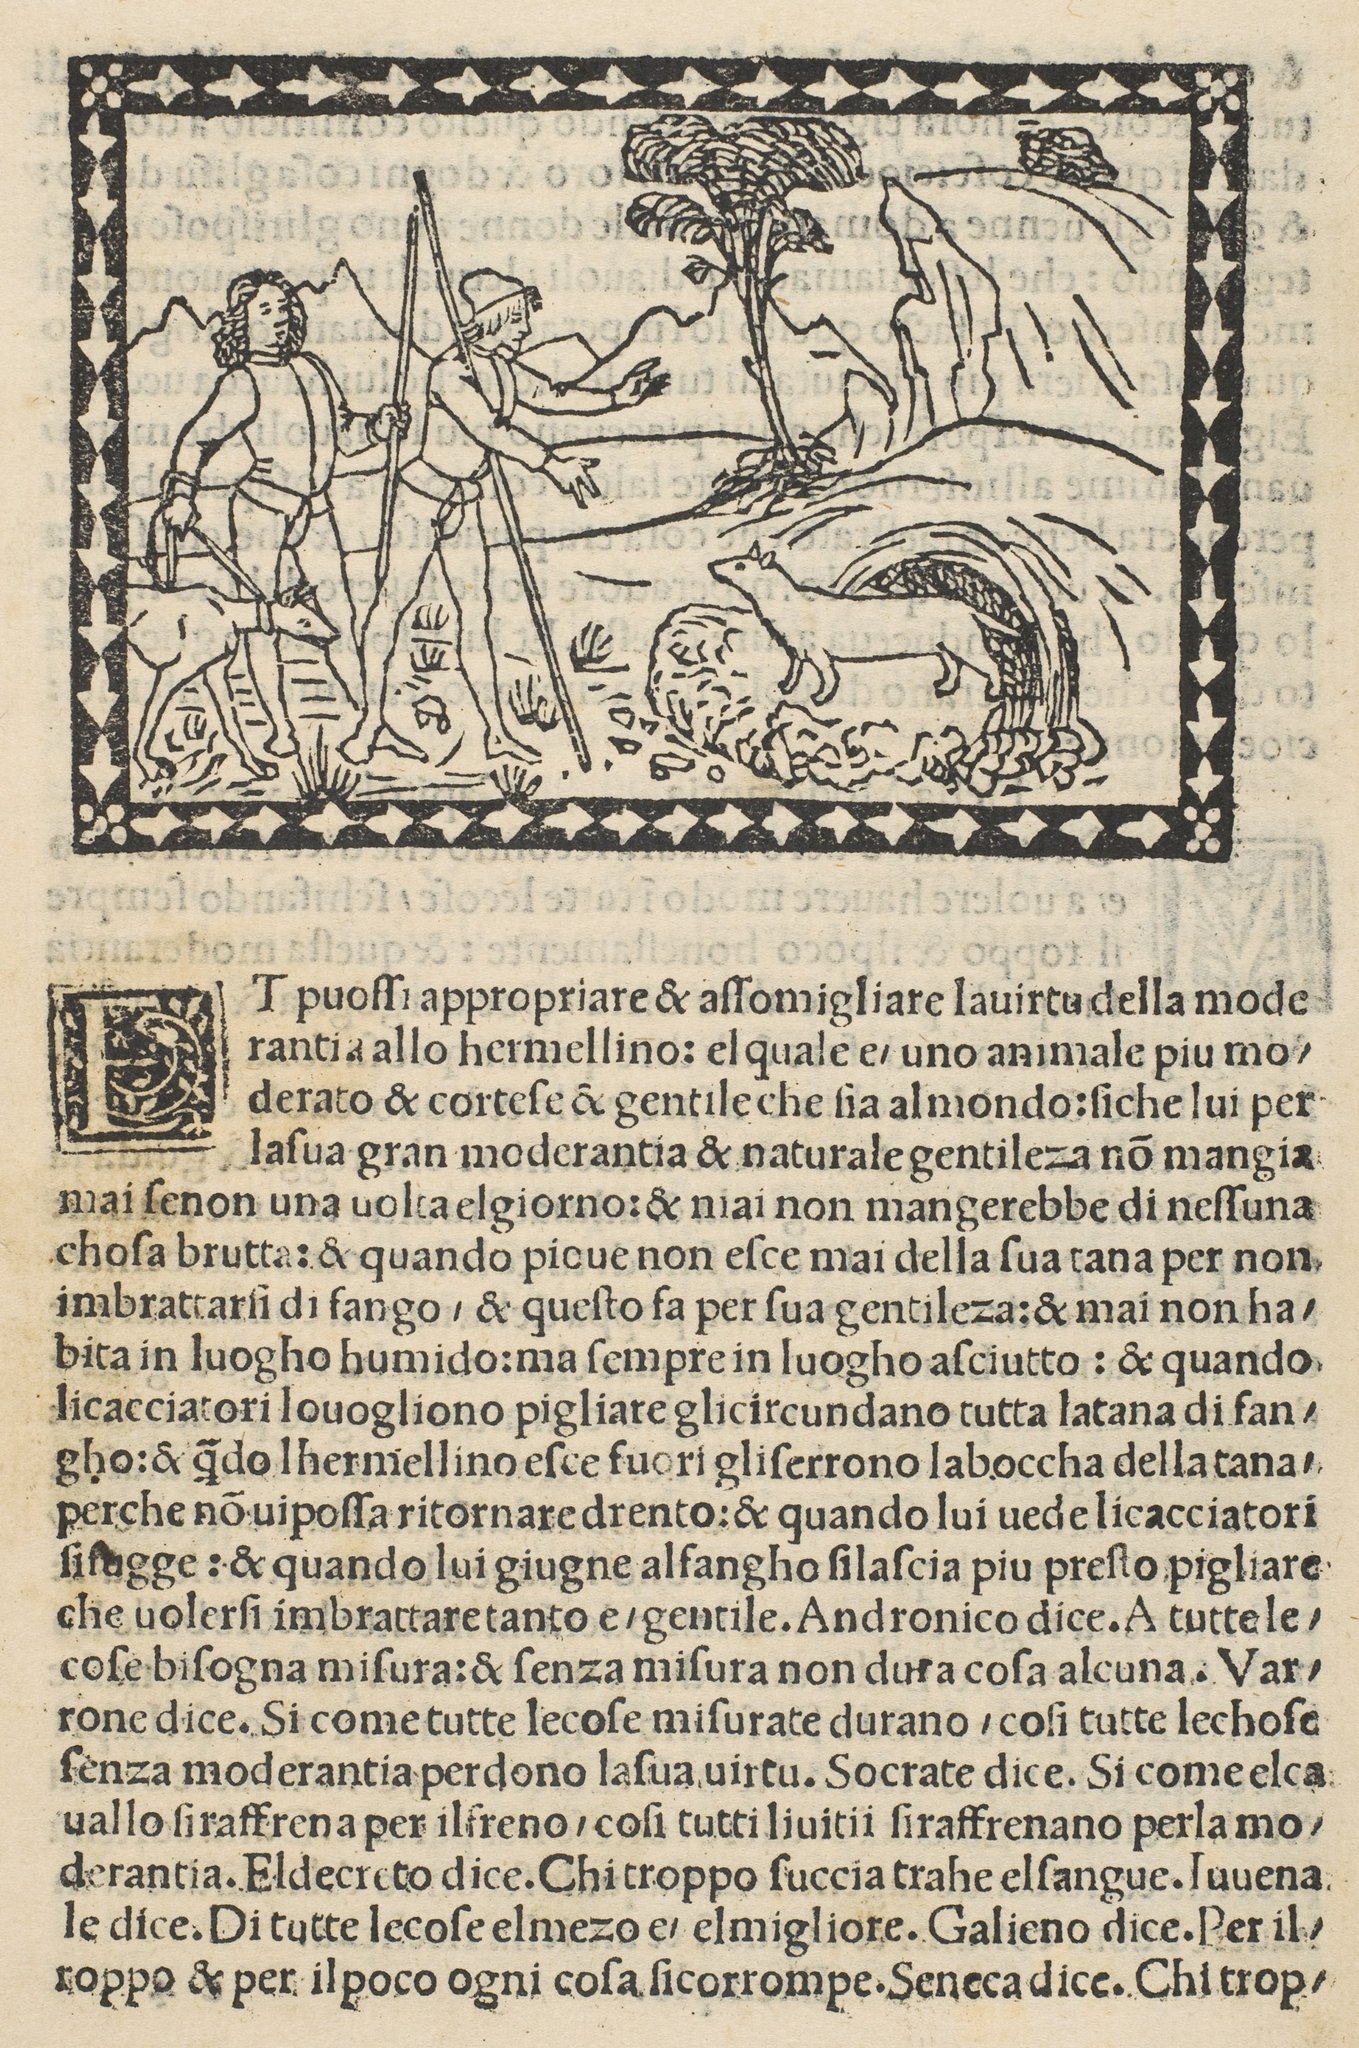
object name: book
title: Fior di virtu hystoriato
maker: gianstephano di carlo da pavia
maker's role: publisher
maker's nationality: italian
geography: italy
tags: animals,men,trees